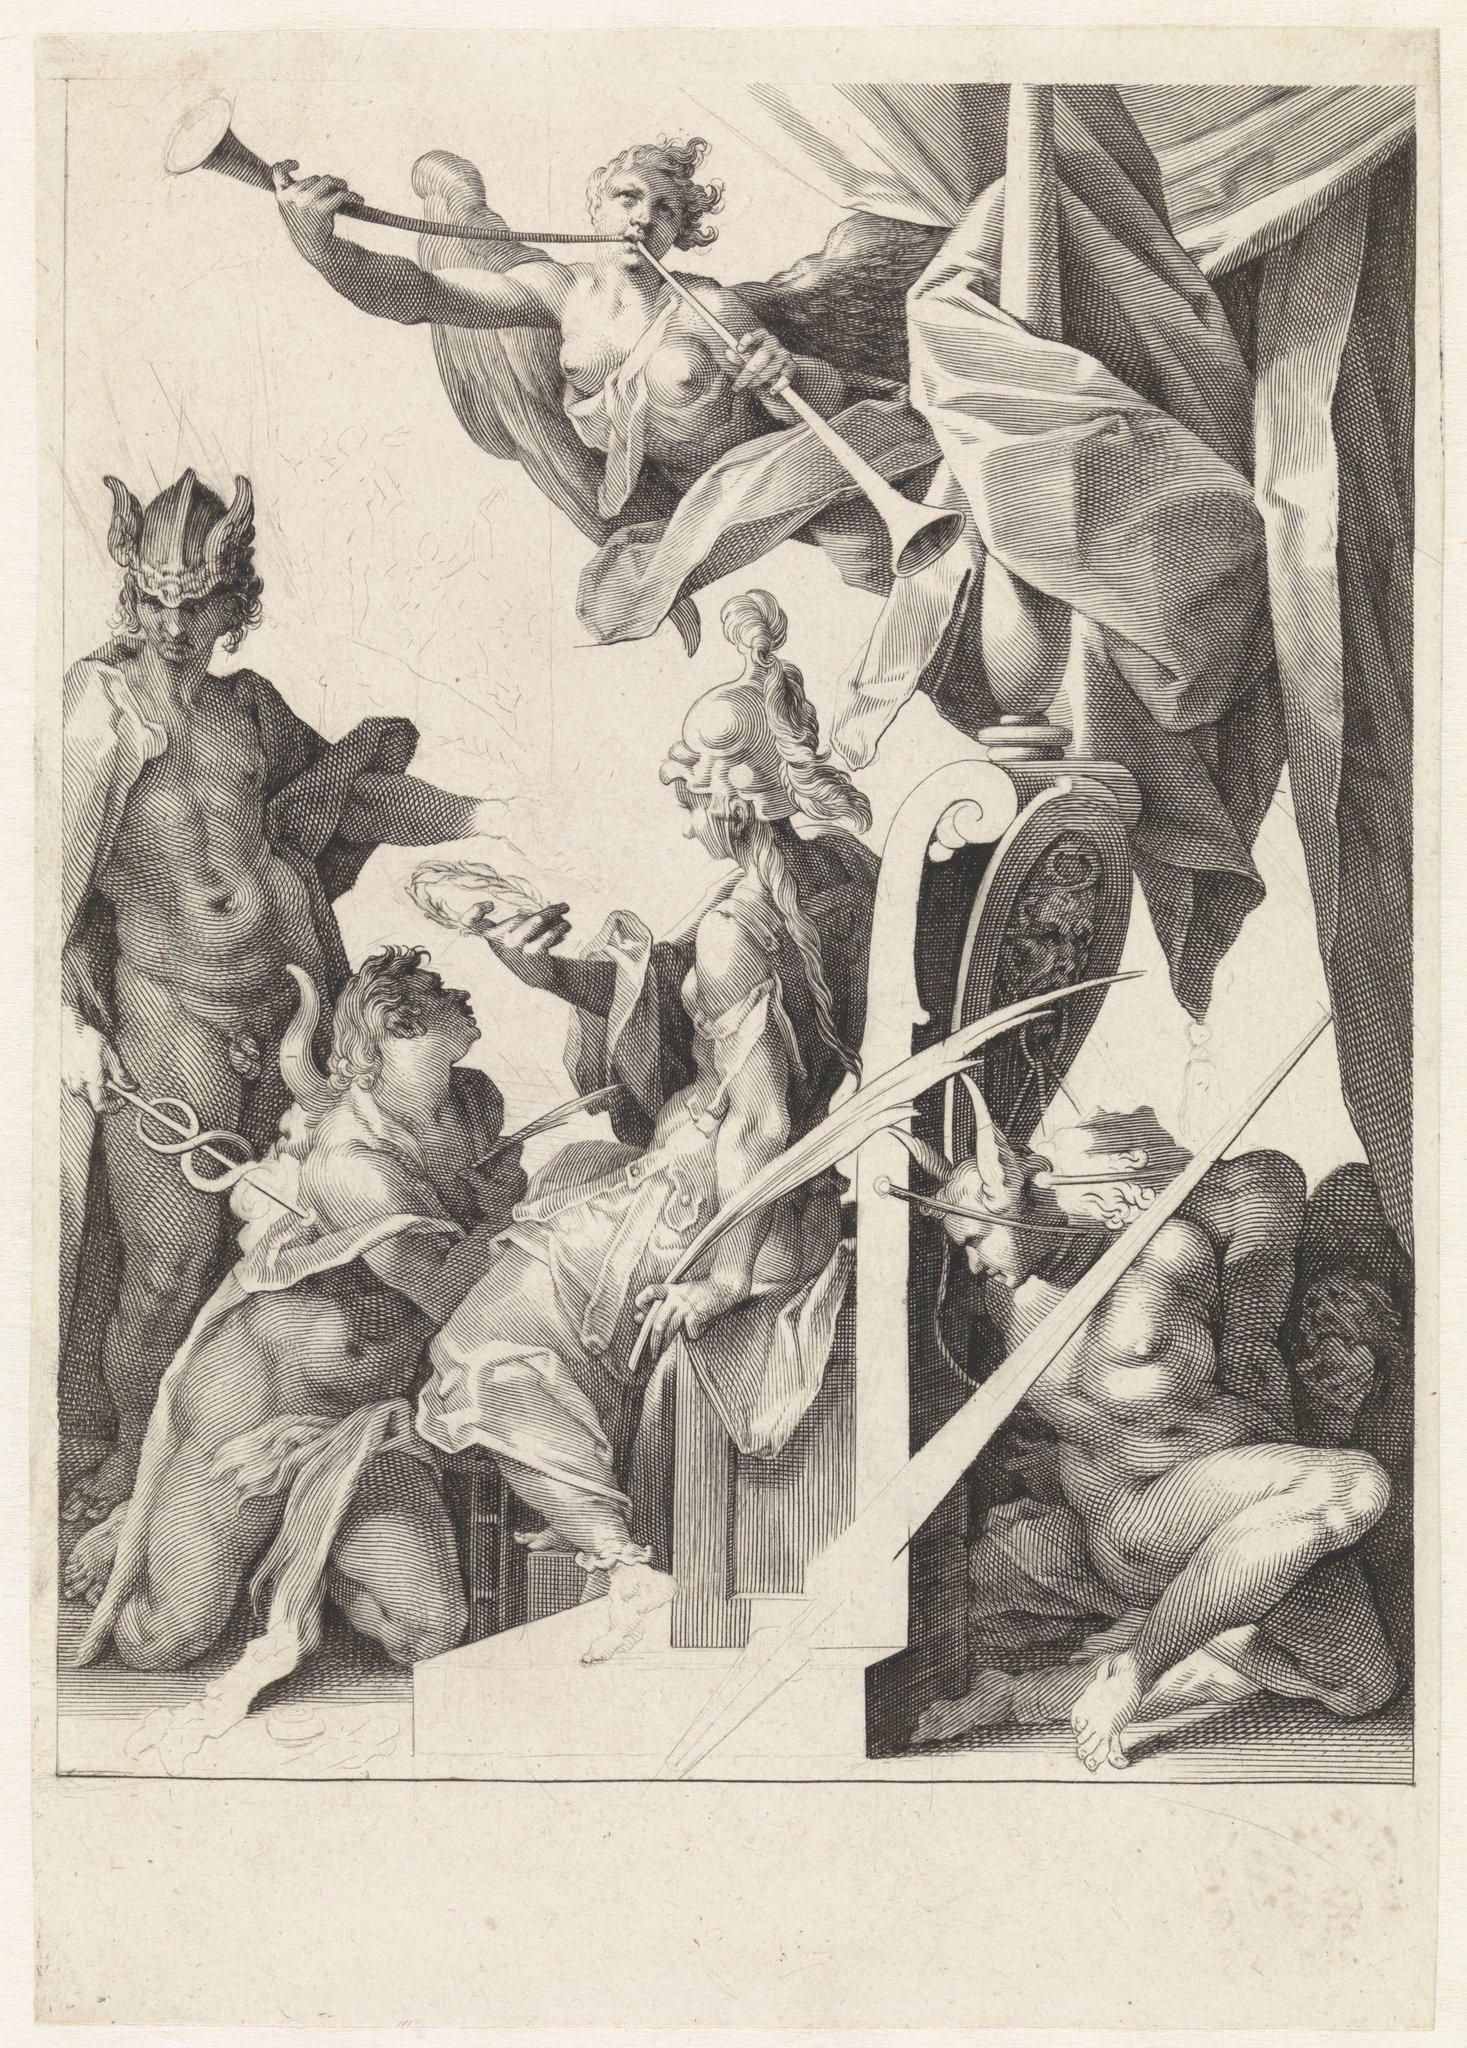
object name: print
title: Mercurius leidt jonge kunstenaars naar Minerva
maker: jan harmensz. muller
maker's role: draughtsman, print maker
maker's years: 1571-1628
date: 1592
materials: paper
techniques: drypoint, engraving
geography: amsterdam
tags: honouring the artist with laurel wreath, minerva as patroness, envy; 'invidia' (ripa) ~ personification of one of the seven deadly sins, sloth, indolence, 'acedia', 'desidia'; 'accidia' (ripa) ~ personification of one of the seven deadly sins, specific aspects, allegorical aspects of mercury; mercury as patron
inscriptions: collector's mark: Lugt 240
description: Mercurius presenteert een jonge kunstenaar aan Minerva, die hem met een lauwerkrans kroont. Boven de troon blaast Faam de trompet. Achter de troon zitten de vastgebonden Nijd, Luiheid en Ondeugd.